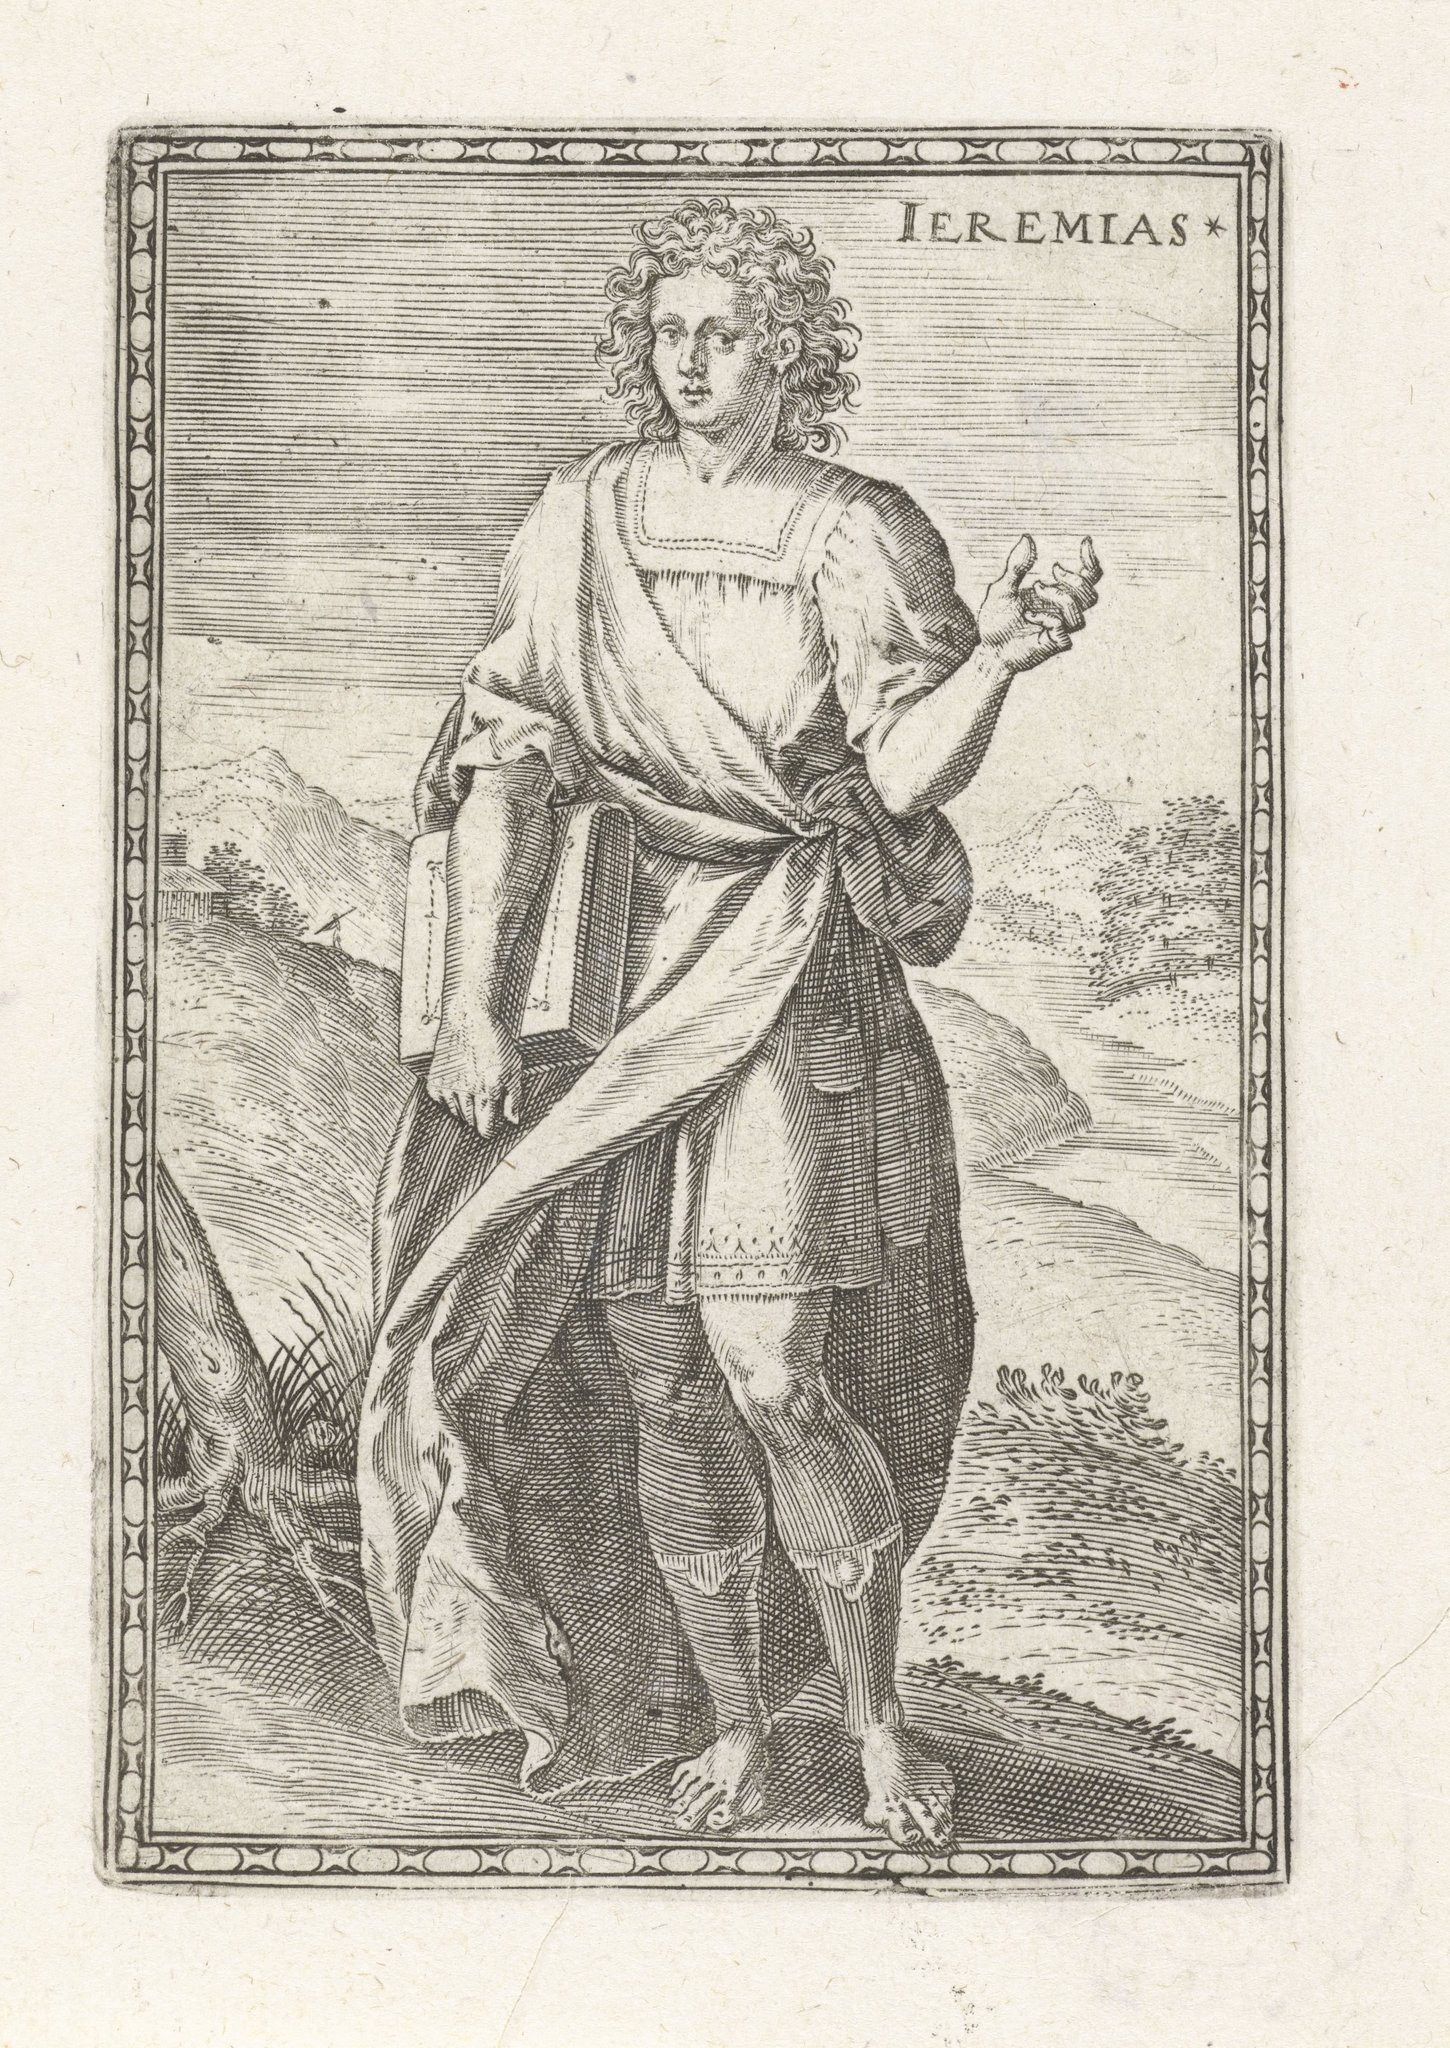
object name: print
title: Personen uit het Oude Testament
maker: johann sadeler (i)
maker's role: print maker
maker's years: 1550-1600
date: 1575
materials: paper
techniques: engraving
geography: antwerp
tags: jeremiah (not in biblical context); possible attributes: book or scroll, 'the seething pot'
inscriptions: collector's mark: Lugt 240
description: De profeet Jeremia als jonge man. In zijn rechterhand een boek. De dertigste prent van een 39-delige reeks met als onderwerp personen uit het Oude Testament.